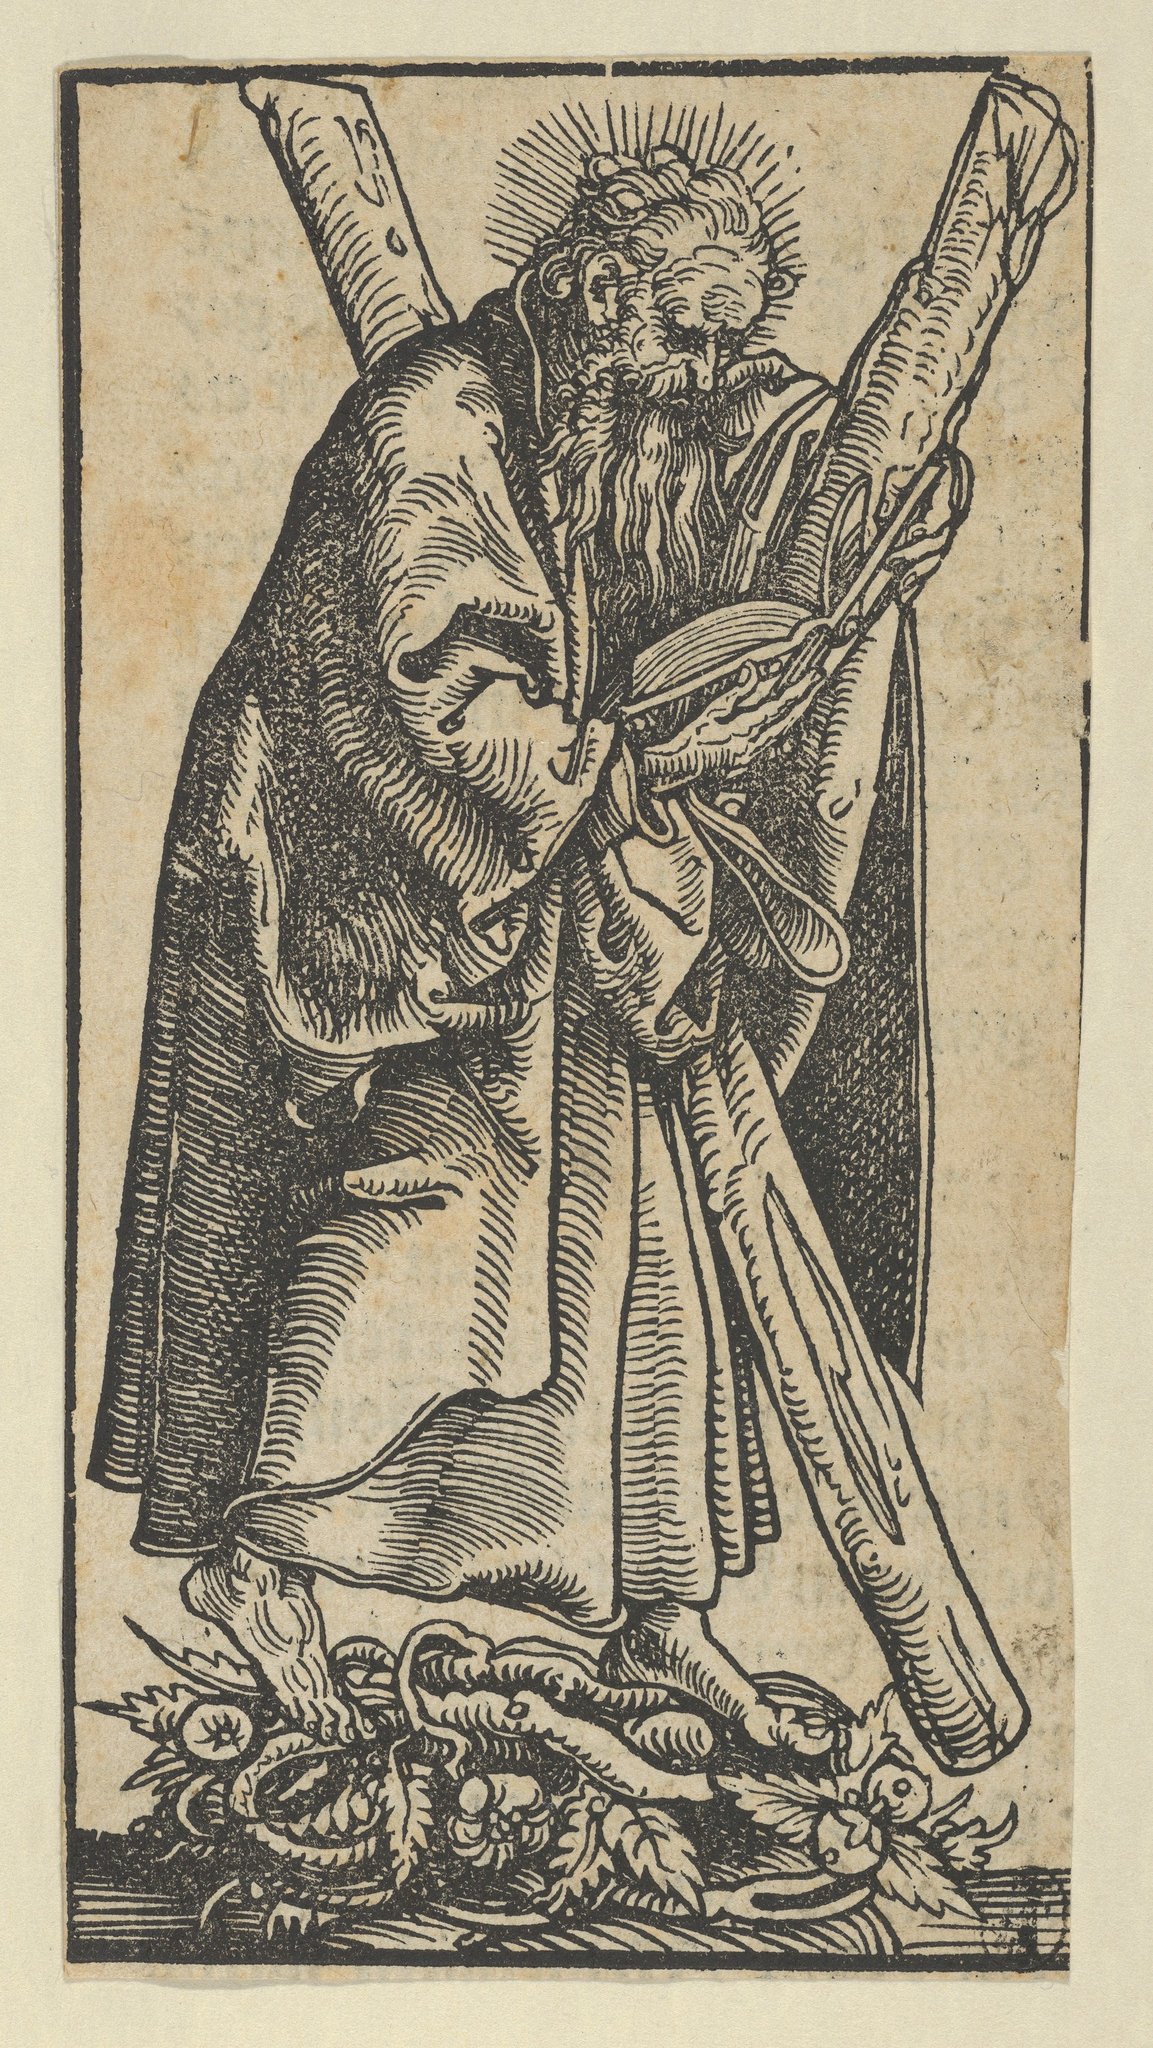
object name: print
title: Silver Statuette of St. Andrew, from the "Wittenberg Reliquaries"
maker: lucas cranach the elder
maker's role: artist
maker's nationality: german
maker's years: 1472-1553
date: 1472-1553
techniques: woodcut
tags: saints